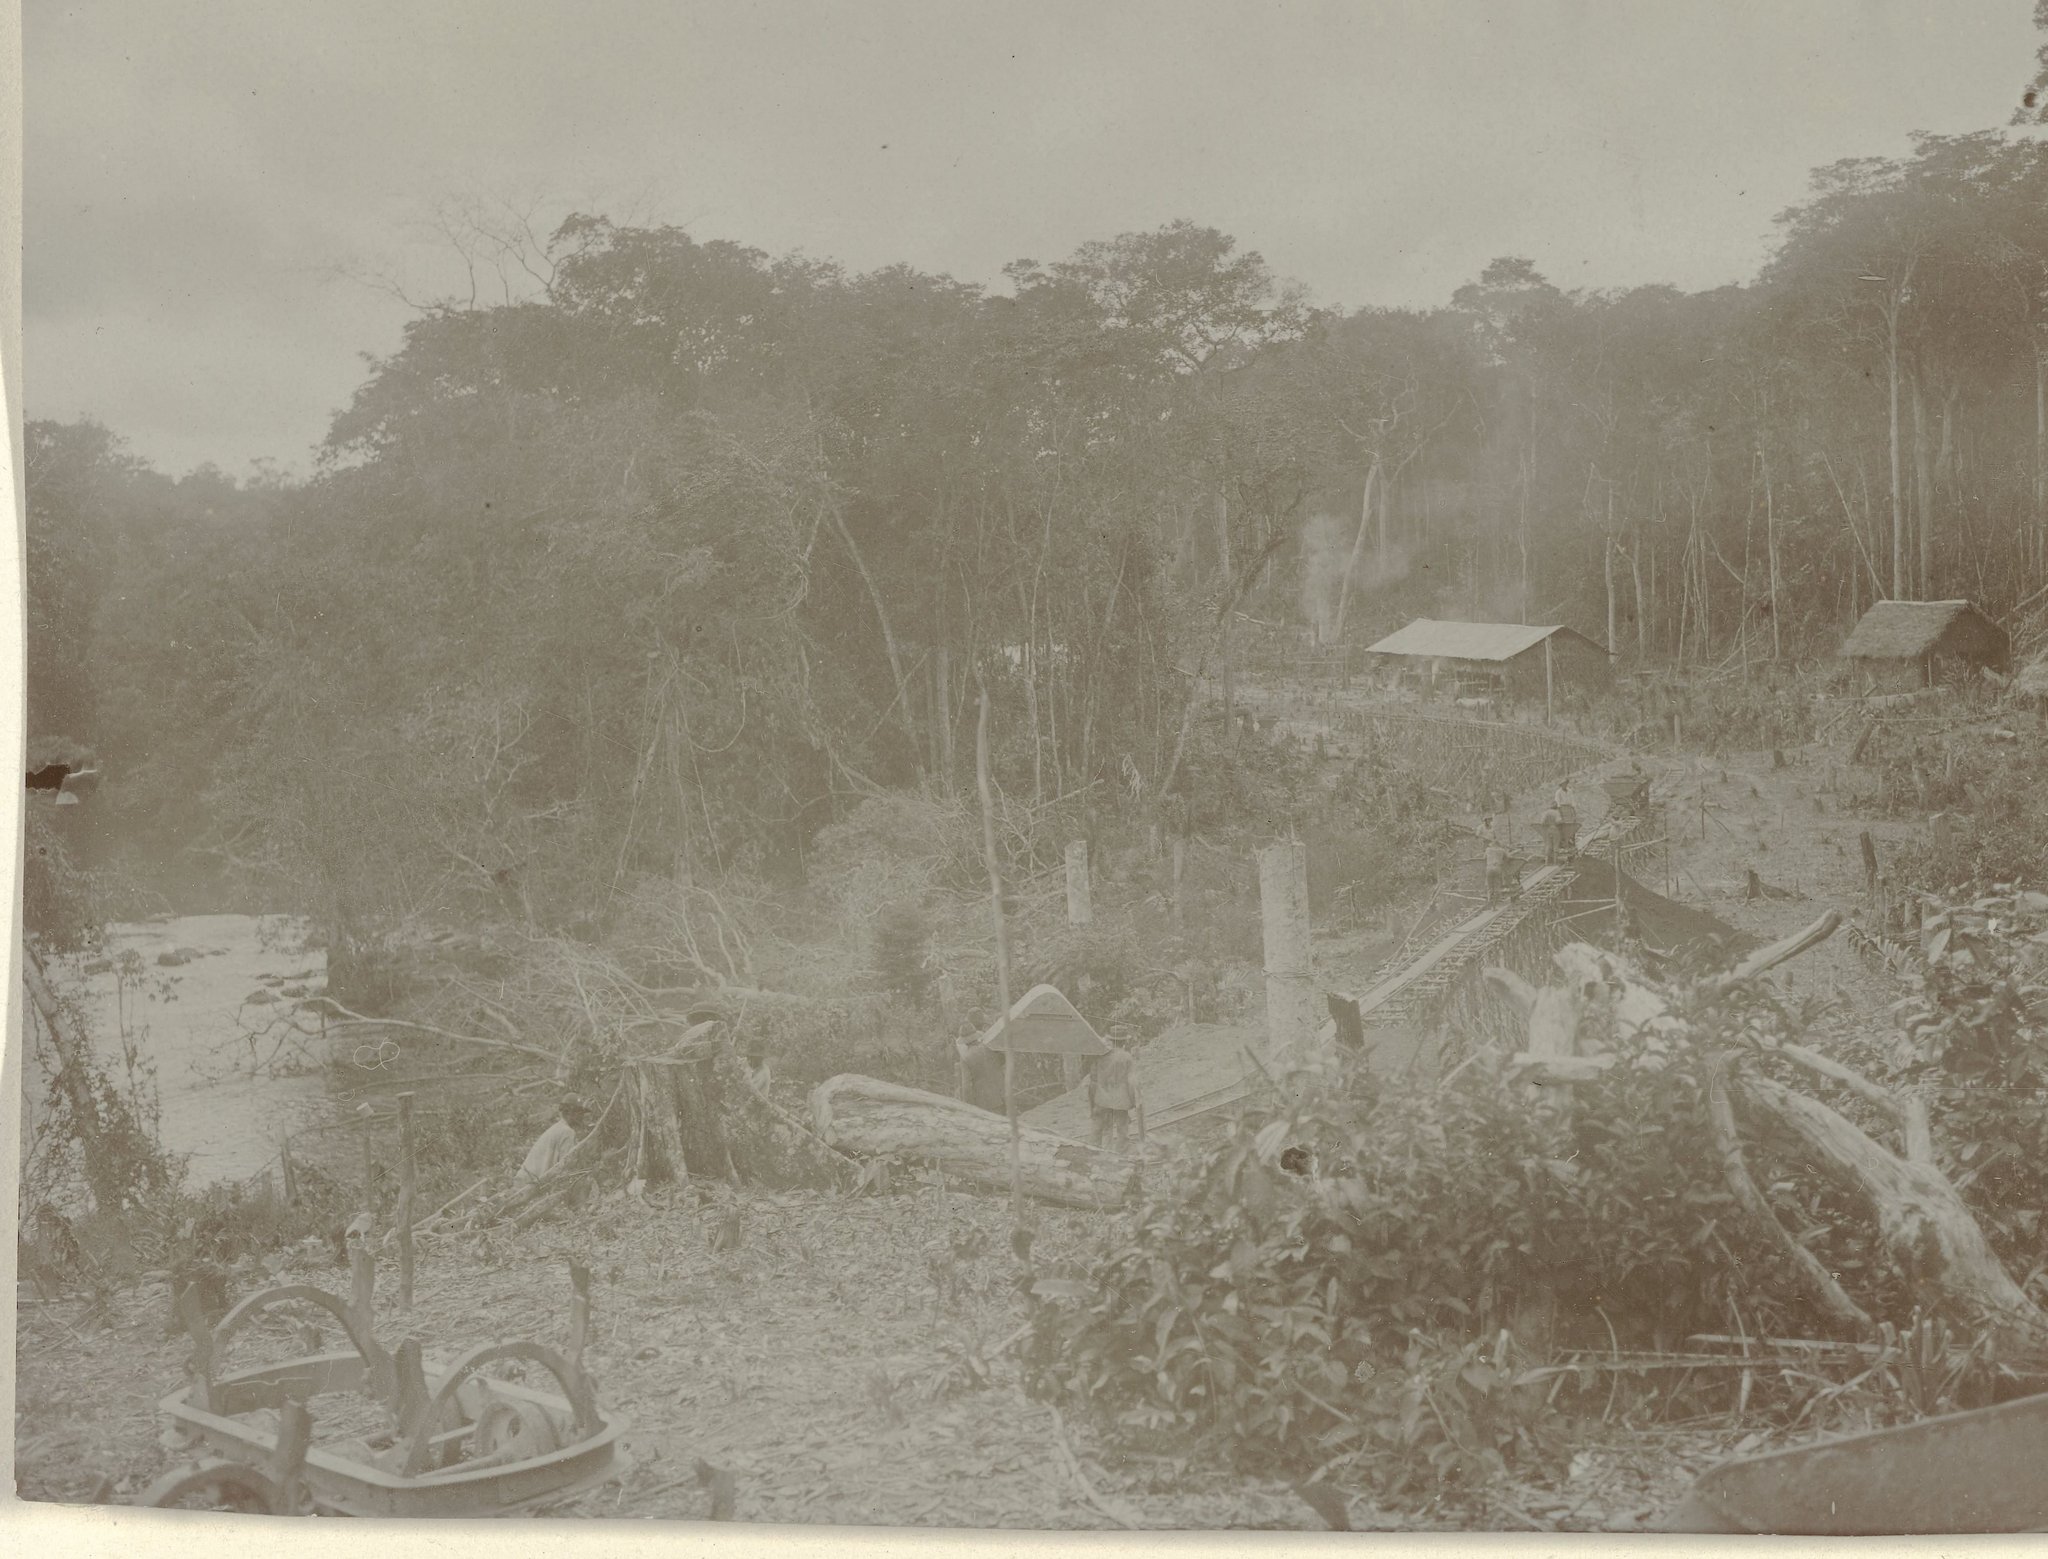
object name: photograph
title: Aanleg van de spoorweg bij Dam, Suriname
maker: jacob evert wesenhagen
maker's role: amateurfotograaf, arts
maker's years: 1862-1924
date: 1905-1910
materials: photographic support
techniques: photography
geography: suriname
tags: railway, train, suriname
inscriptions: annotation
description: Arbeiders vervoeren materiaal over een werkbrug, bij Dam op km 173. Aanleg van de Lawaspoorweg in Suriname in de jaren 1903-1912. Onderdeel van een groep objecten afkomstig van de familie Wesenhagen in Suriname.